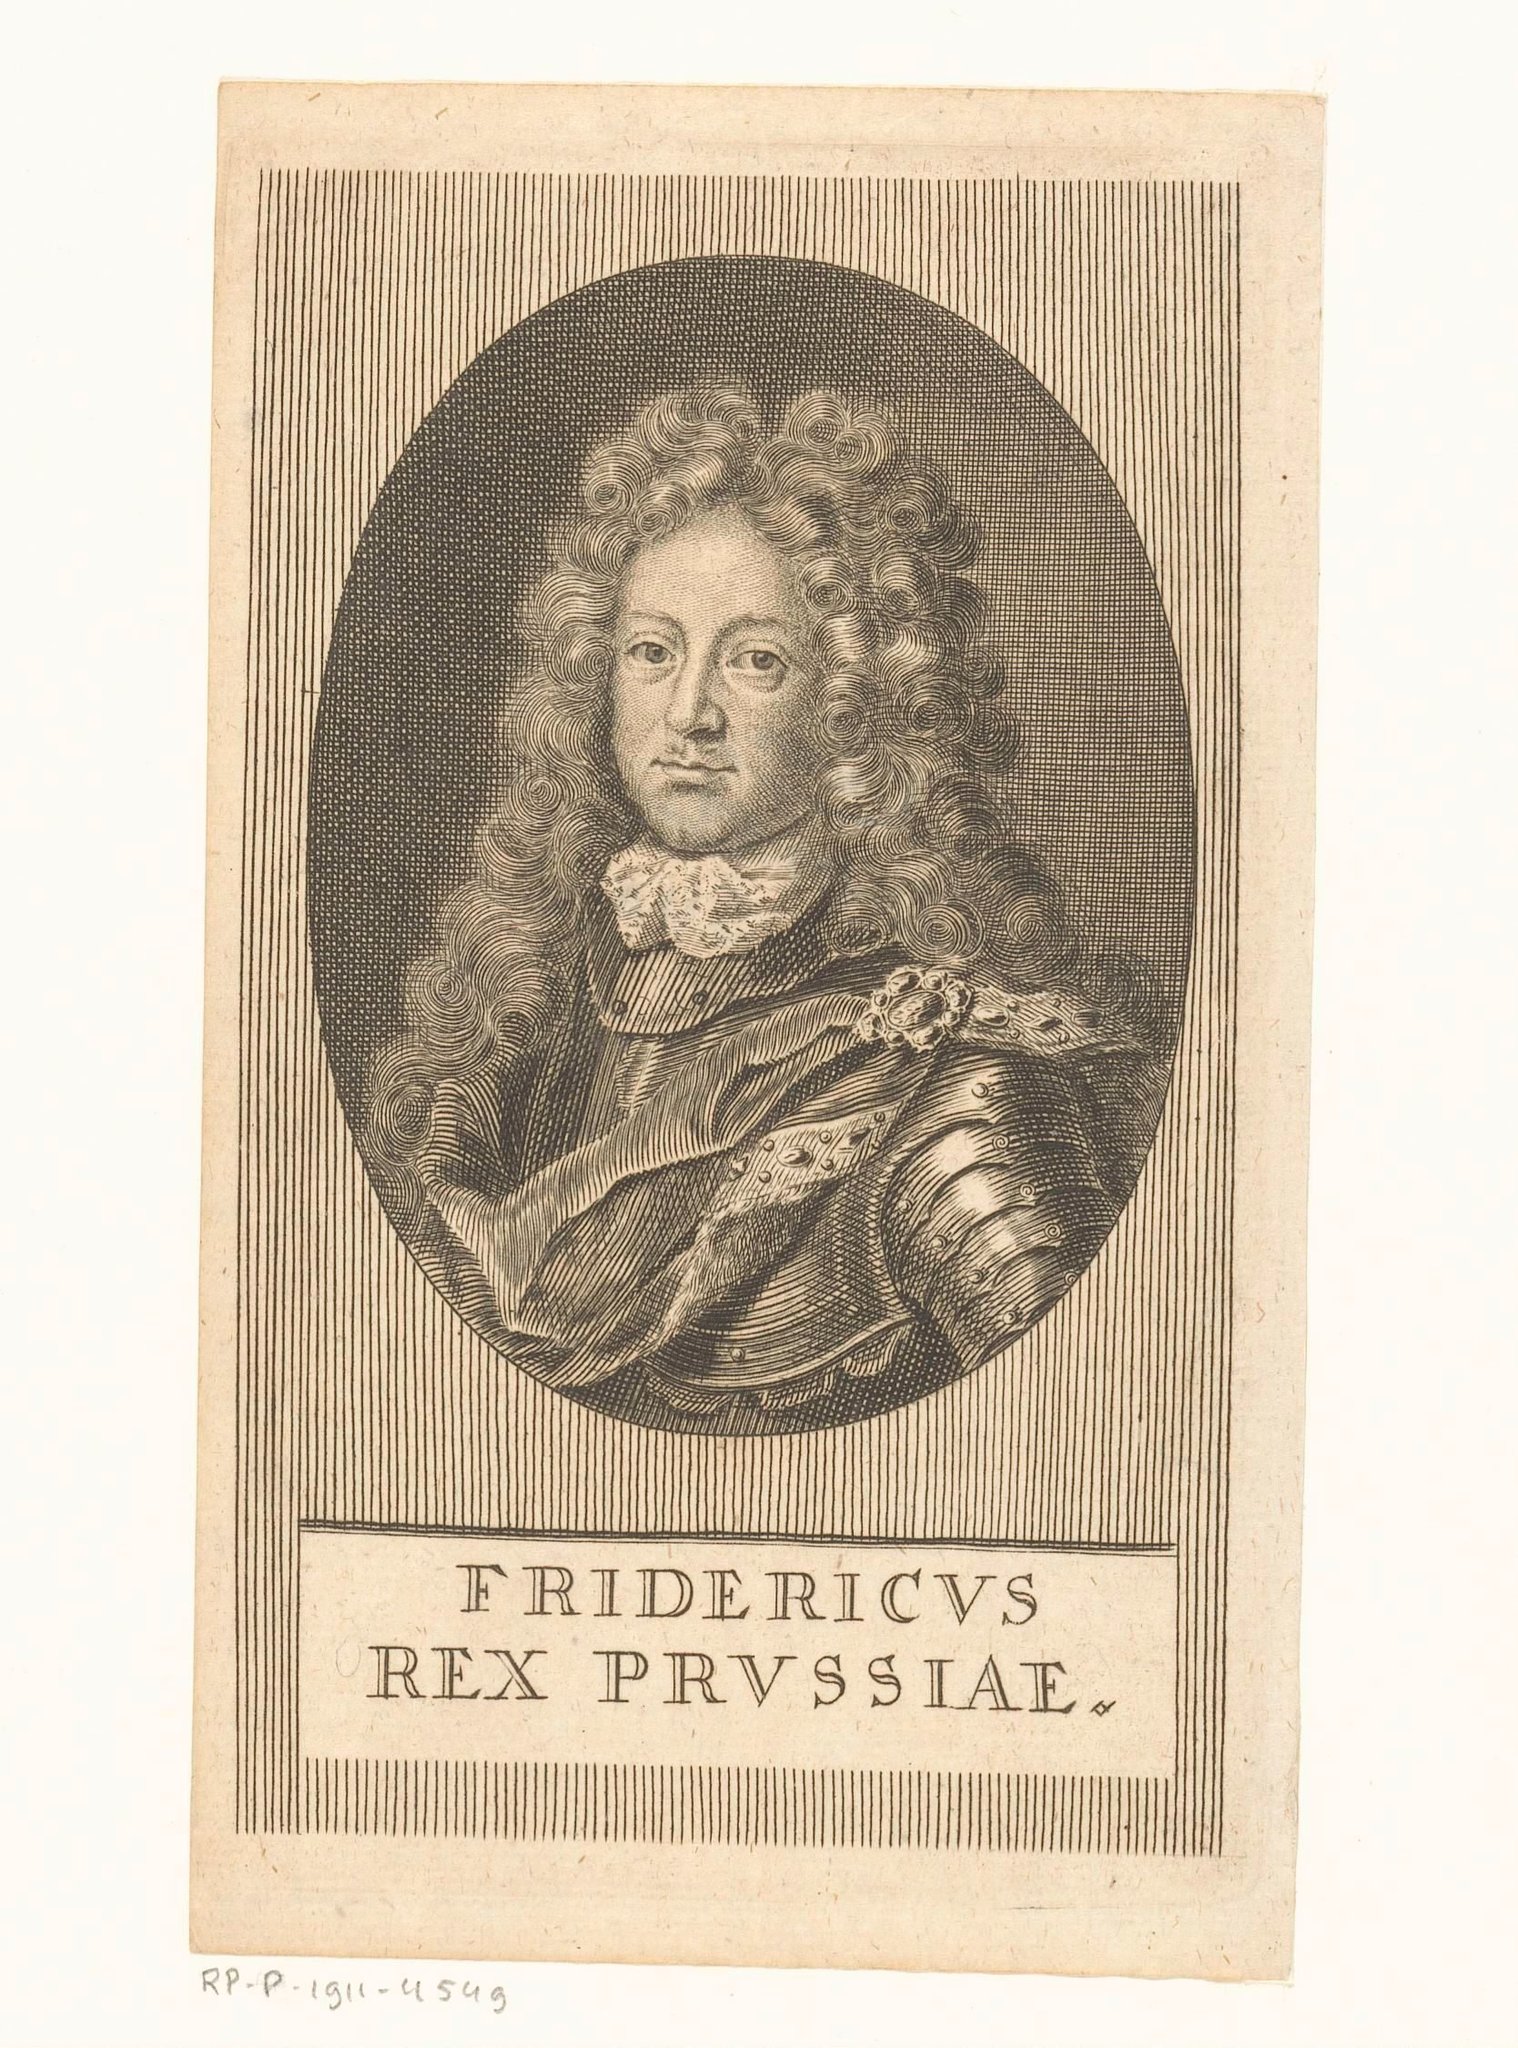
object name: print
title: Portret van Friedrich I, koning van Pruisen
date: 1701-1733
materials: paper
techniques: engraving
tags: berlin, frederik i koning van pruisen, armour, historical persons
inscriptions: collector's mark: Lugt 2228